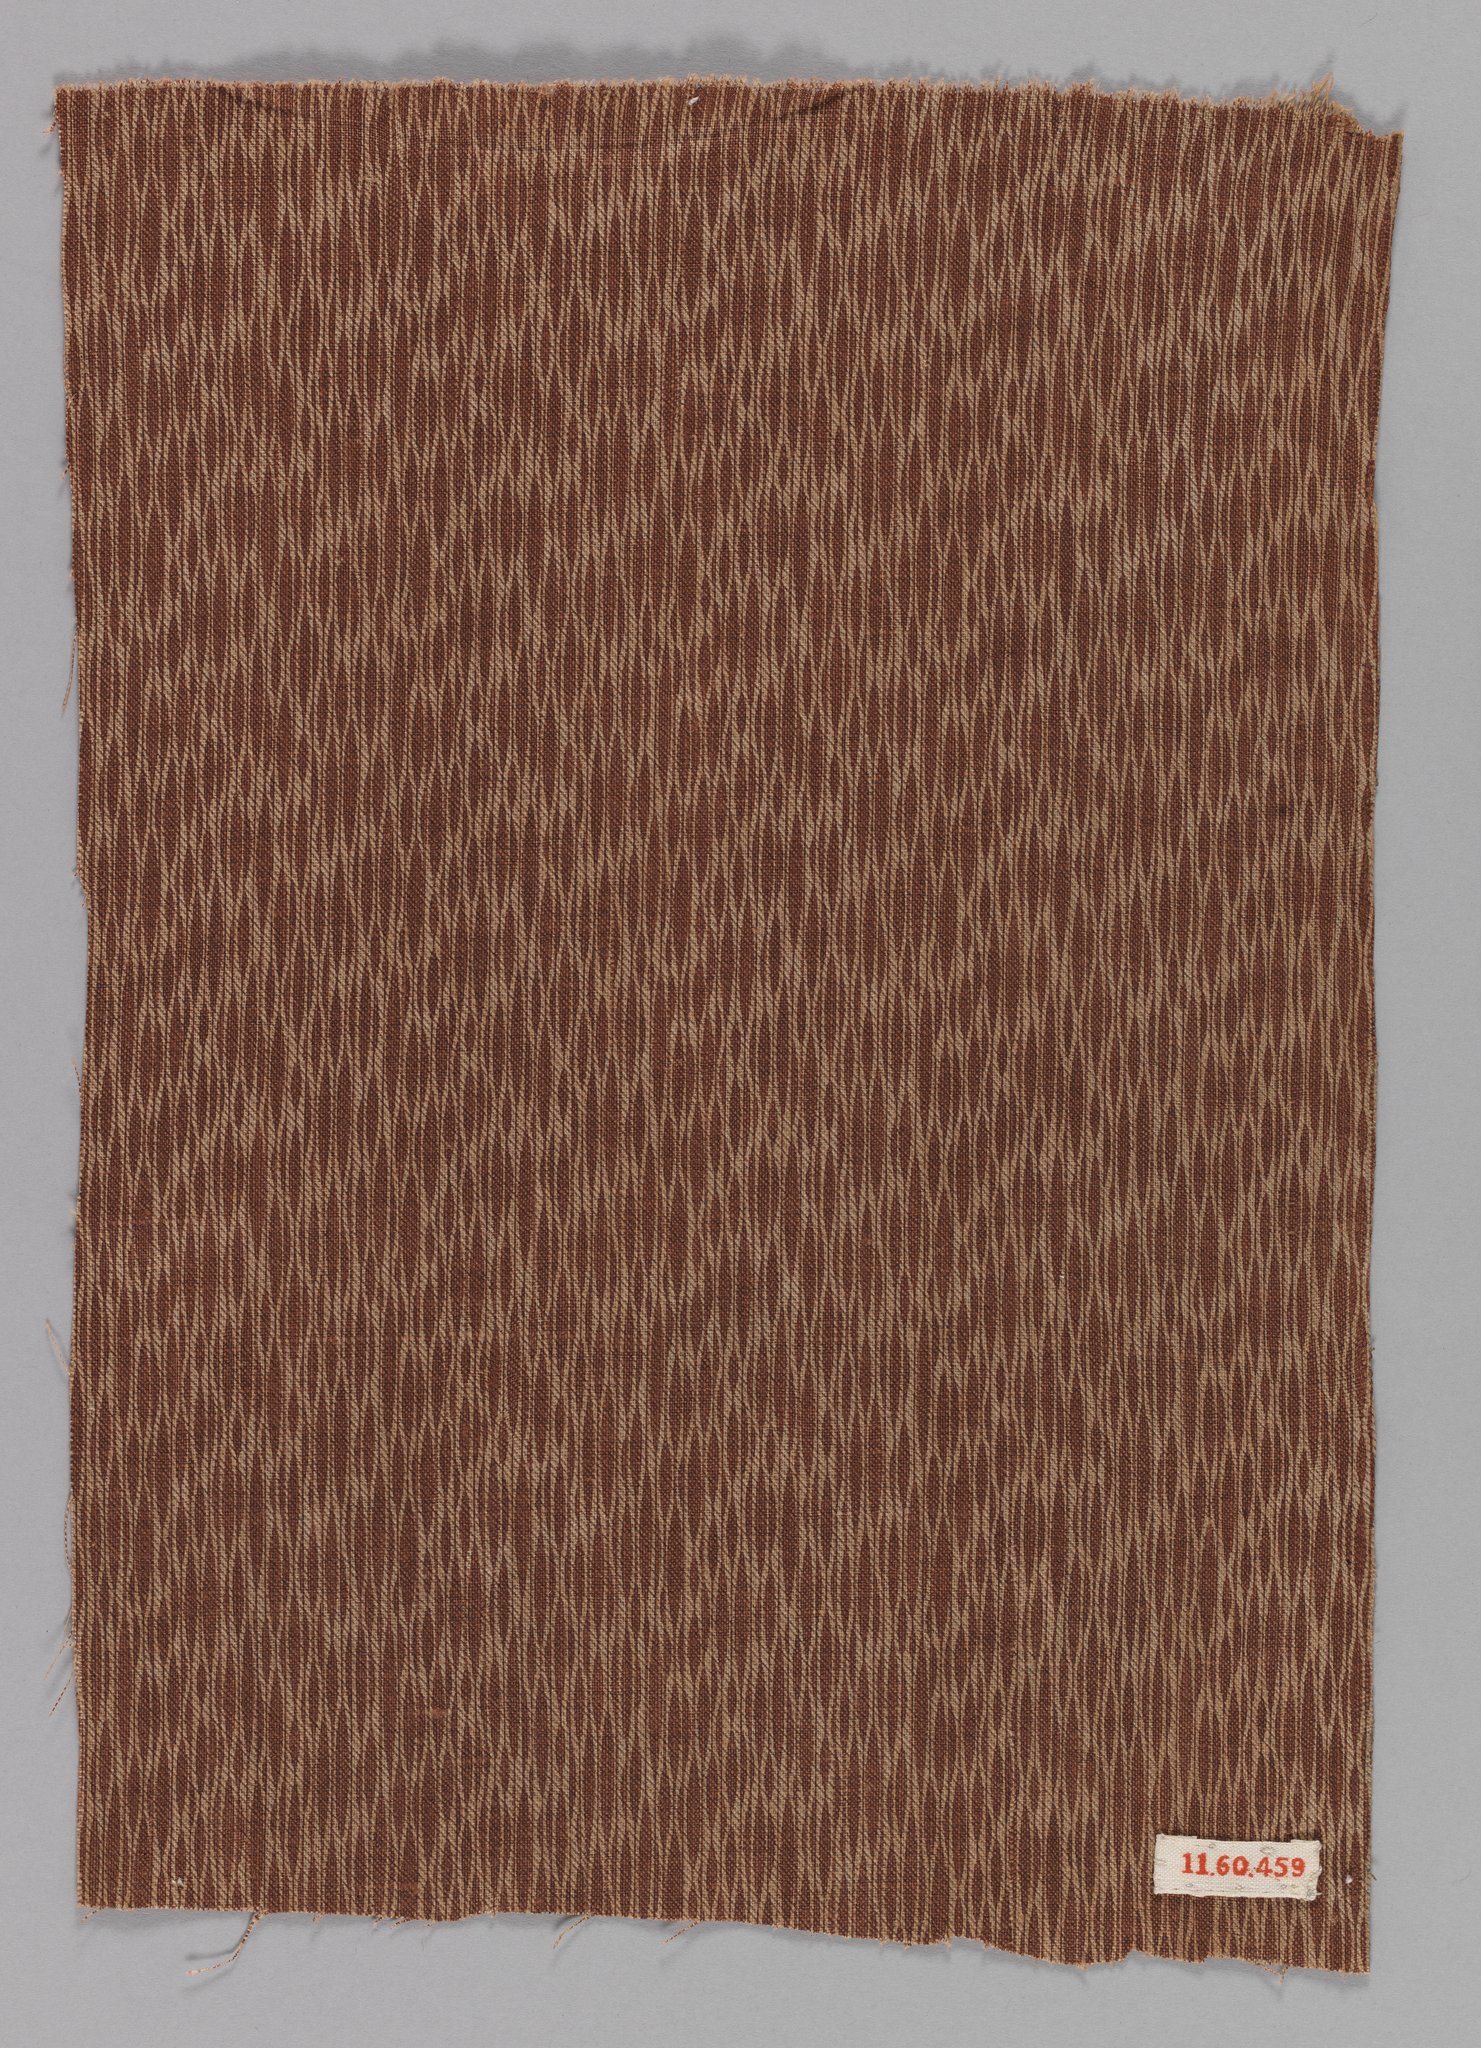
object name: piece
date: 1801-1900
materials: cotton